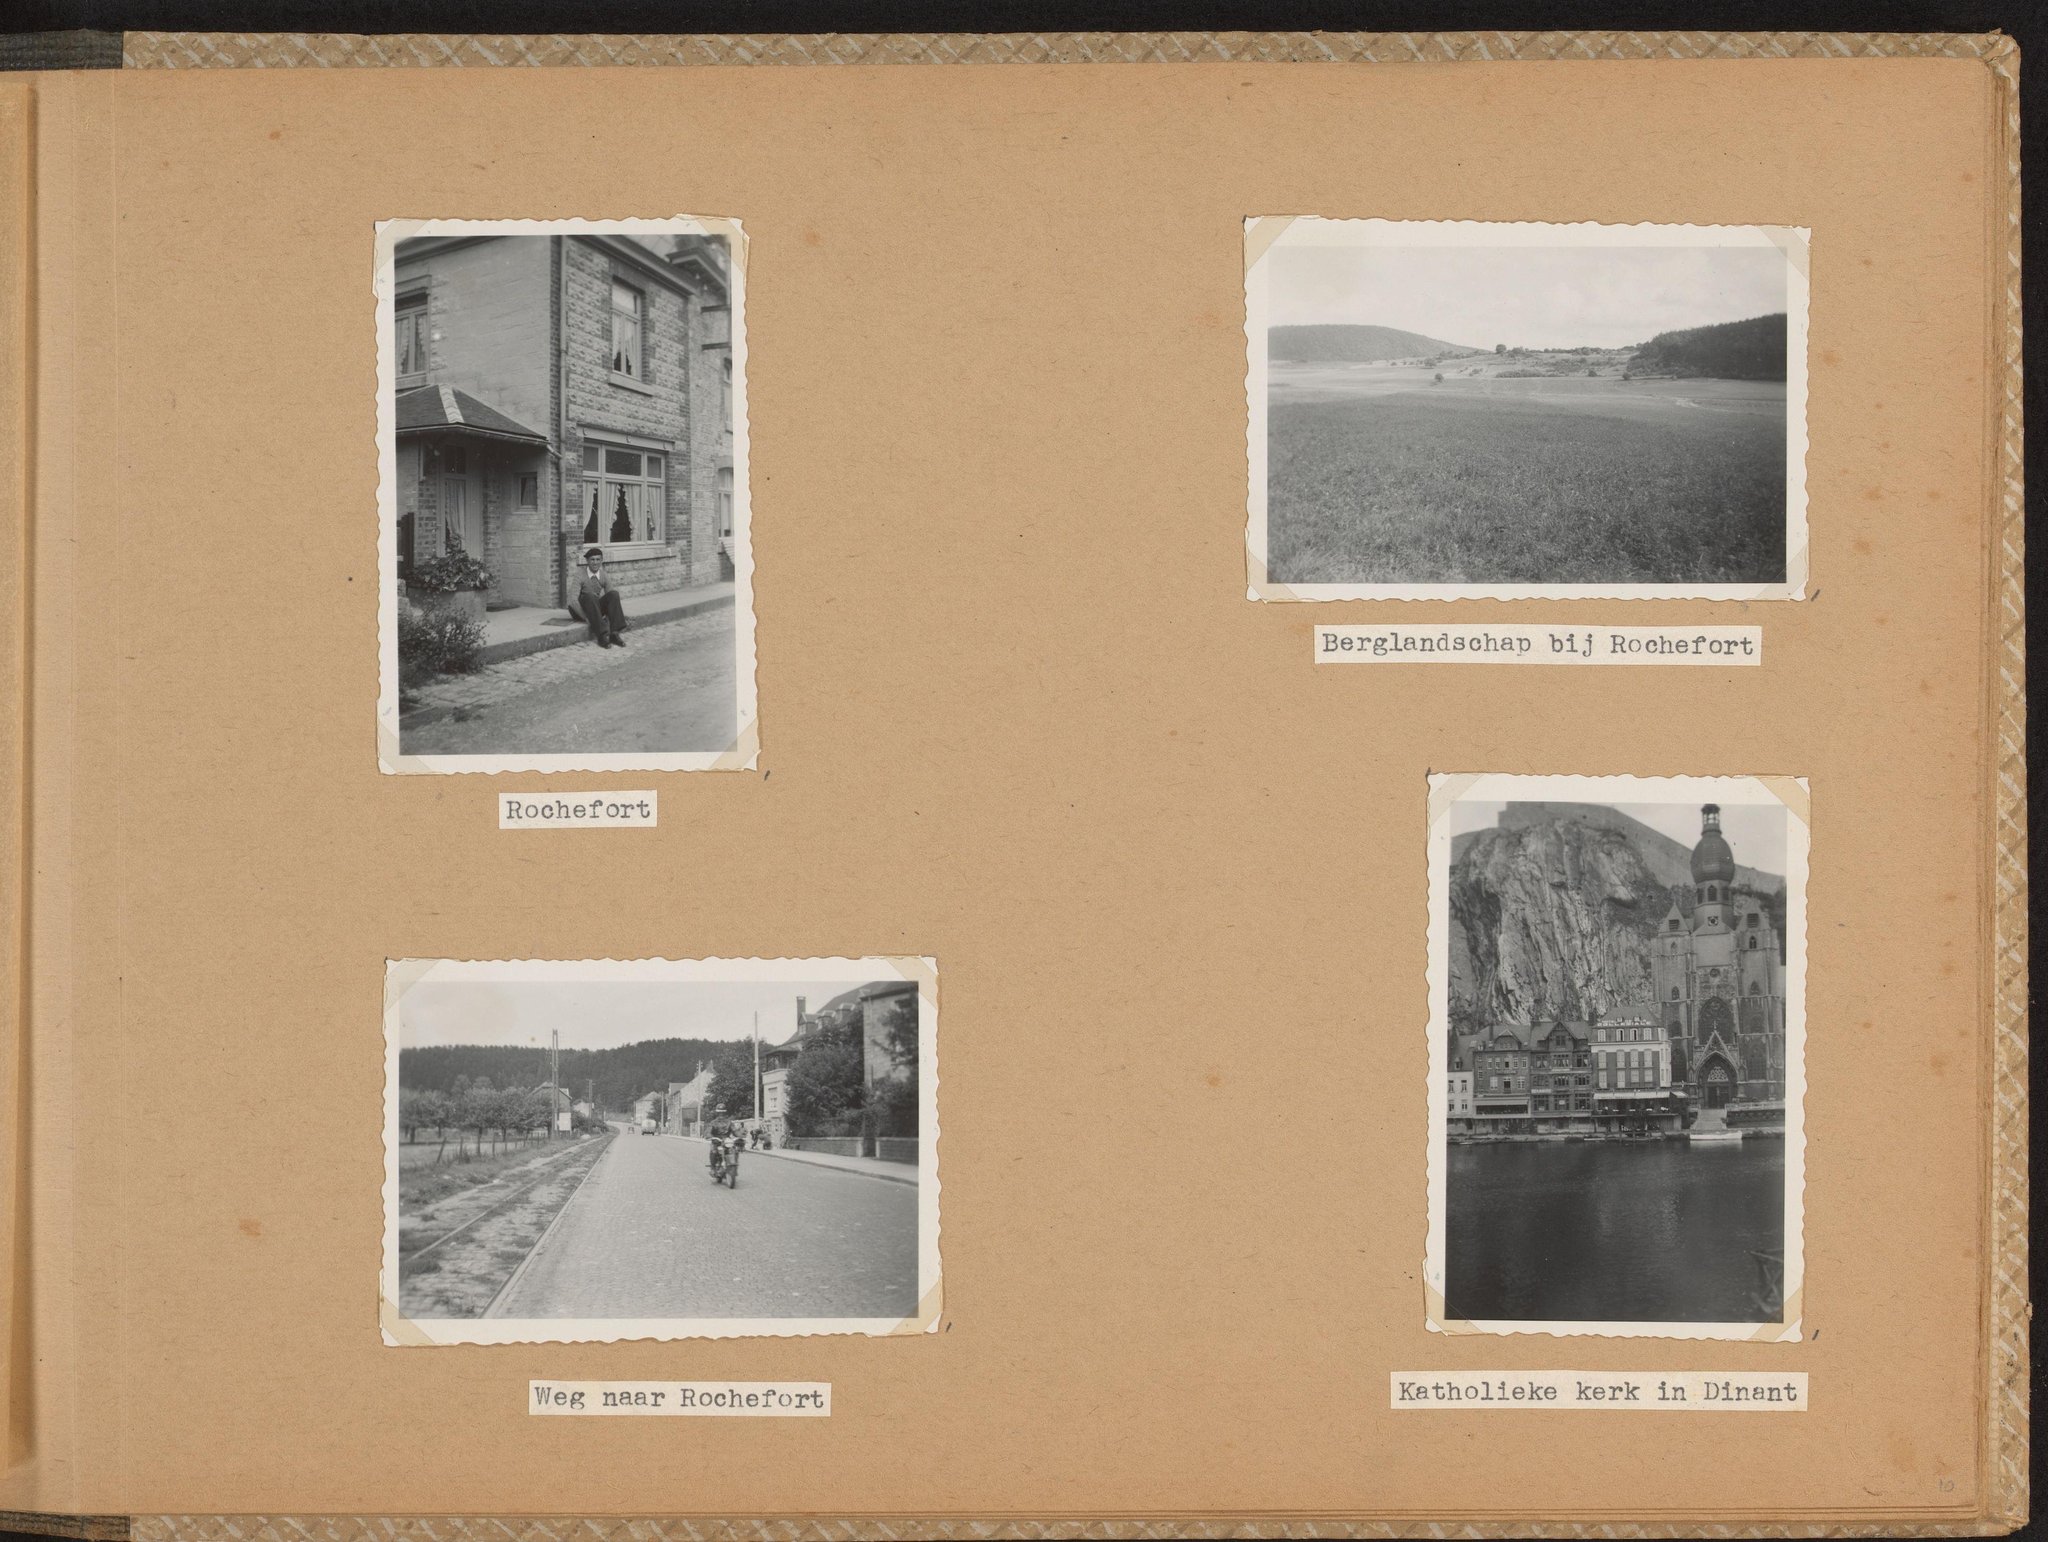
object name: album leaf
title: Rochefort en Dinant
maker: Anonymous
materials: paper, photographic support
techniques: gelatin silver print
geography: belgium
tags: the family travelling, on holiday, outing, pleasure trip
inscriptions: inscription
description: Albumblad met vier foto's van een fietsvakantie. Gezichten te Rochefort en Dinant. Onder de foto's uitgeknipte papiertjes met getypte opschriften. Onderdeel van het tweede fotoalbum met foto's van familievakanties in Nederland, België, Luxemburg en Frankrijk in 1950-1951.